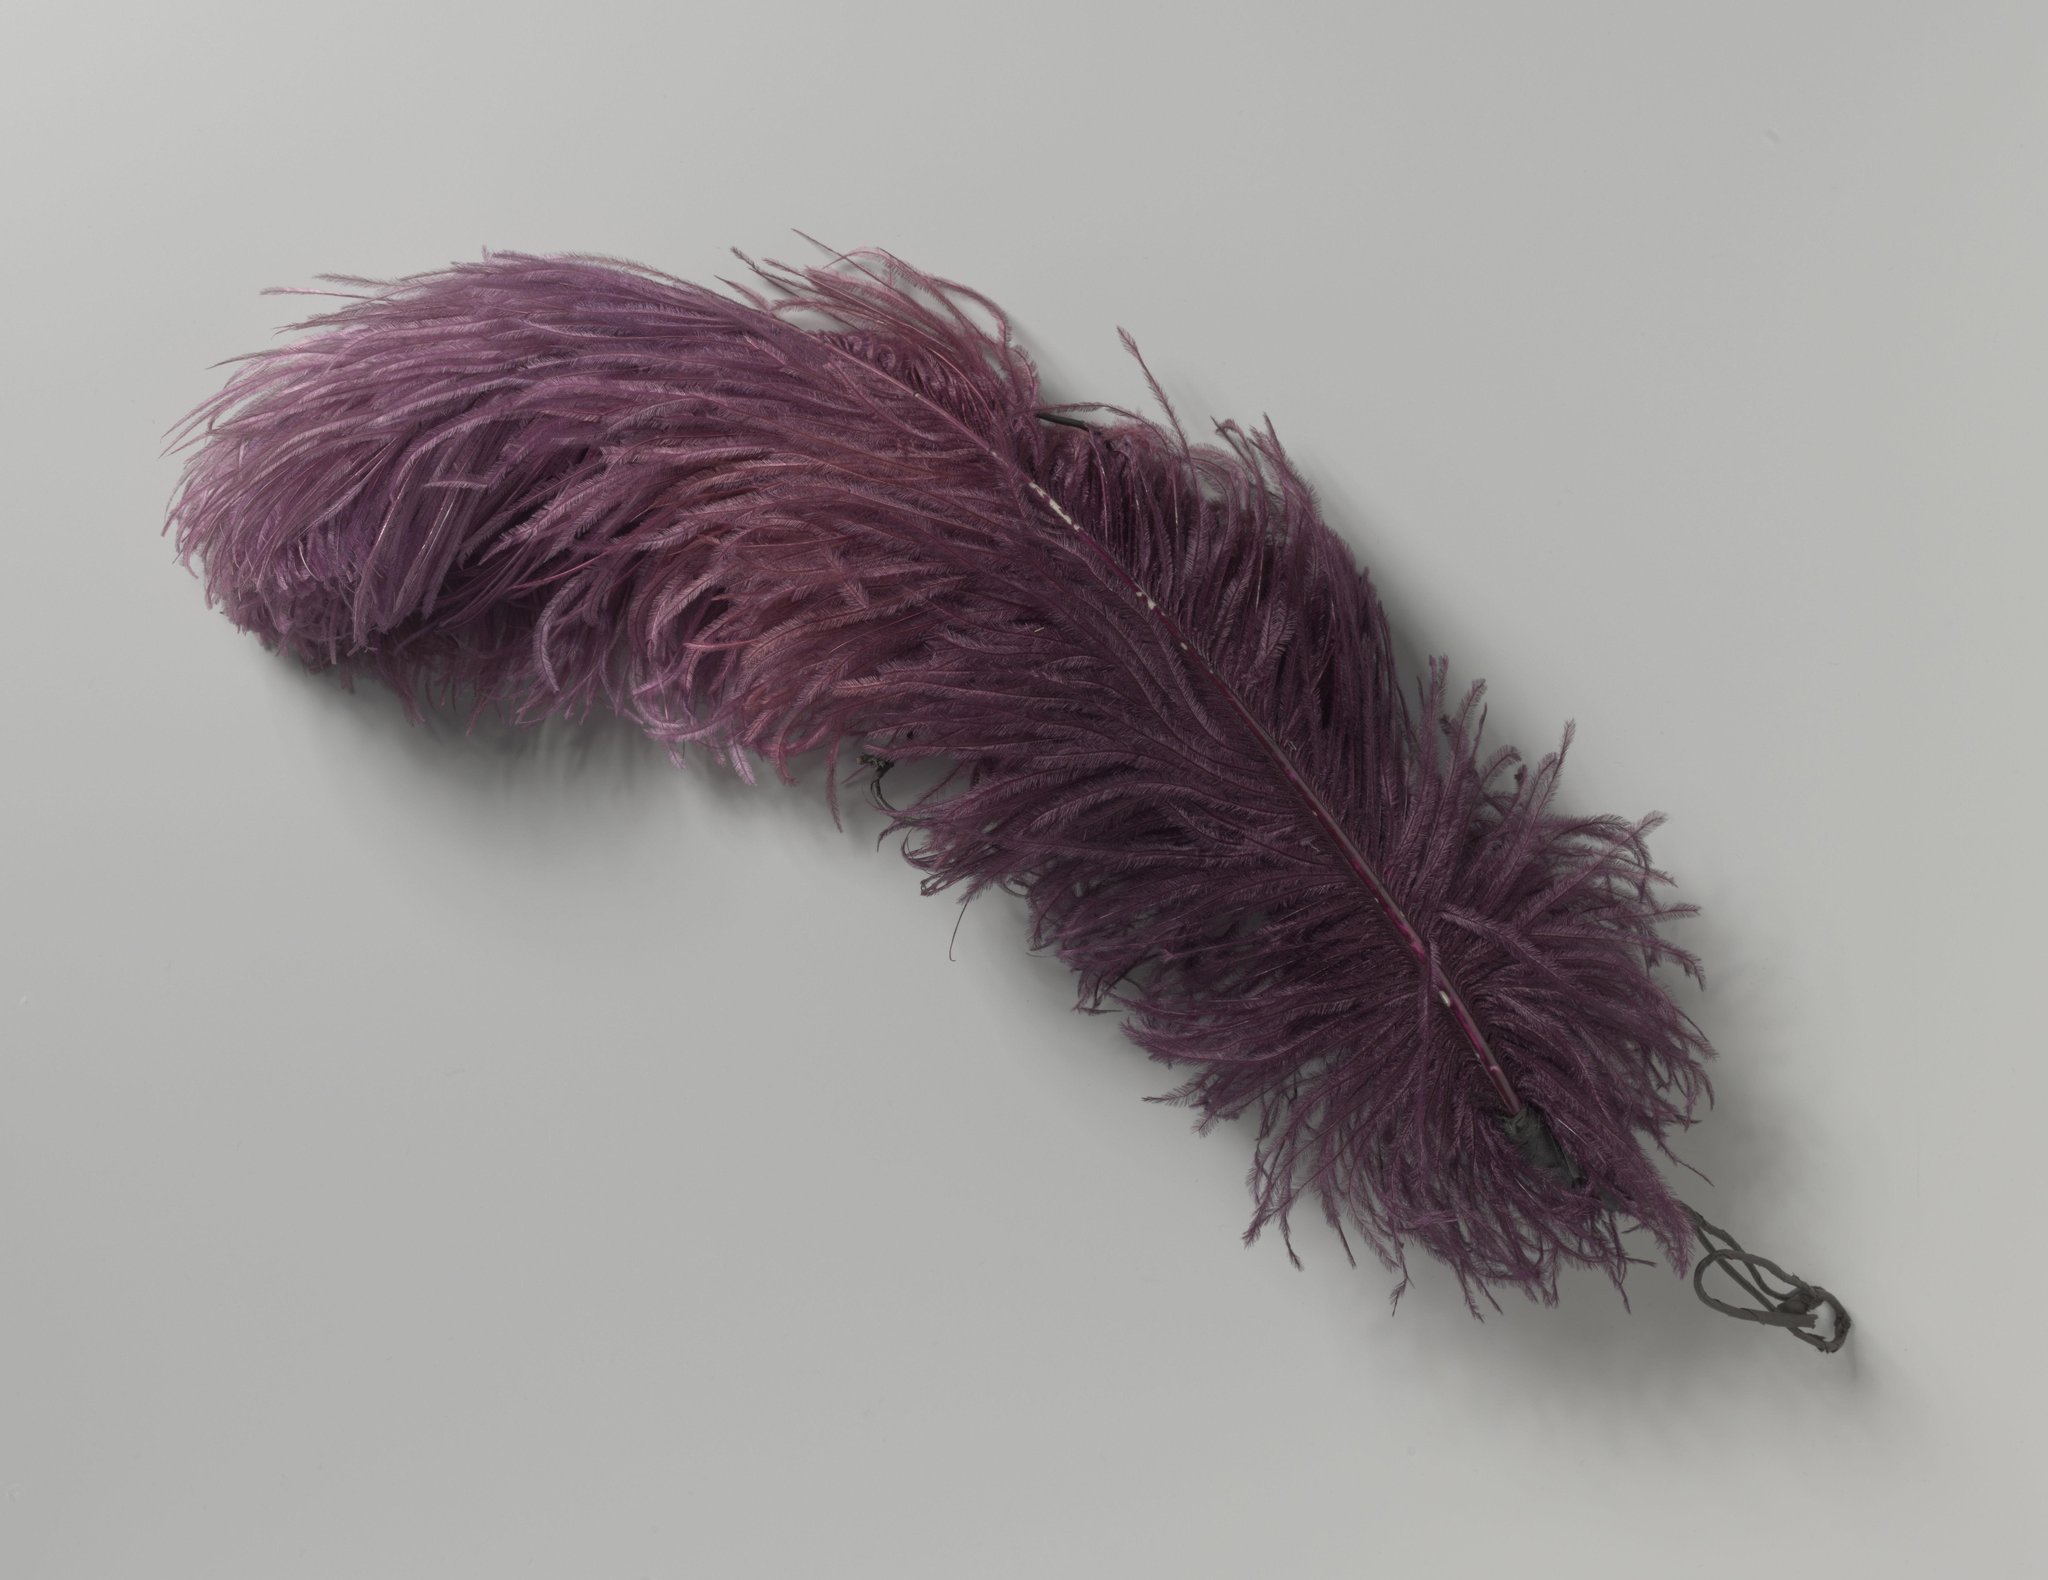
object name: womenswear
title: Struisveer, paars van kleur, met verloop van donker naar licht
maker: Anonymous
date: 1895-1915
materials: metal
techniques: painting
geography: western europe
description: Struisveer, paars van kleur, met verloop van donker naar licht.